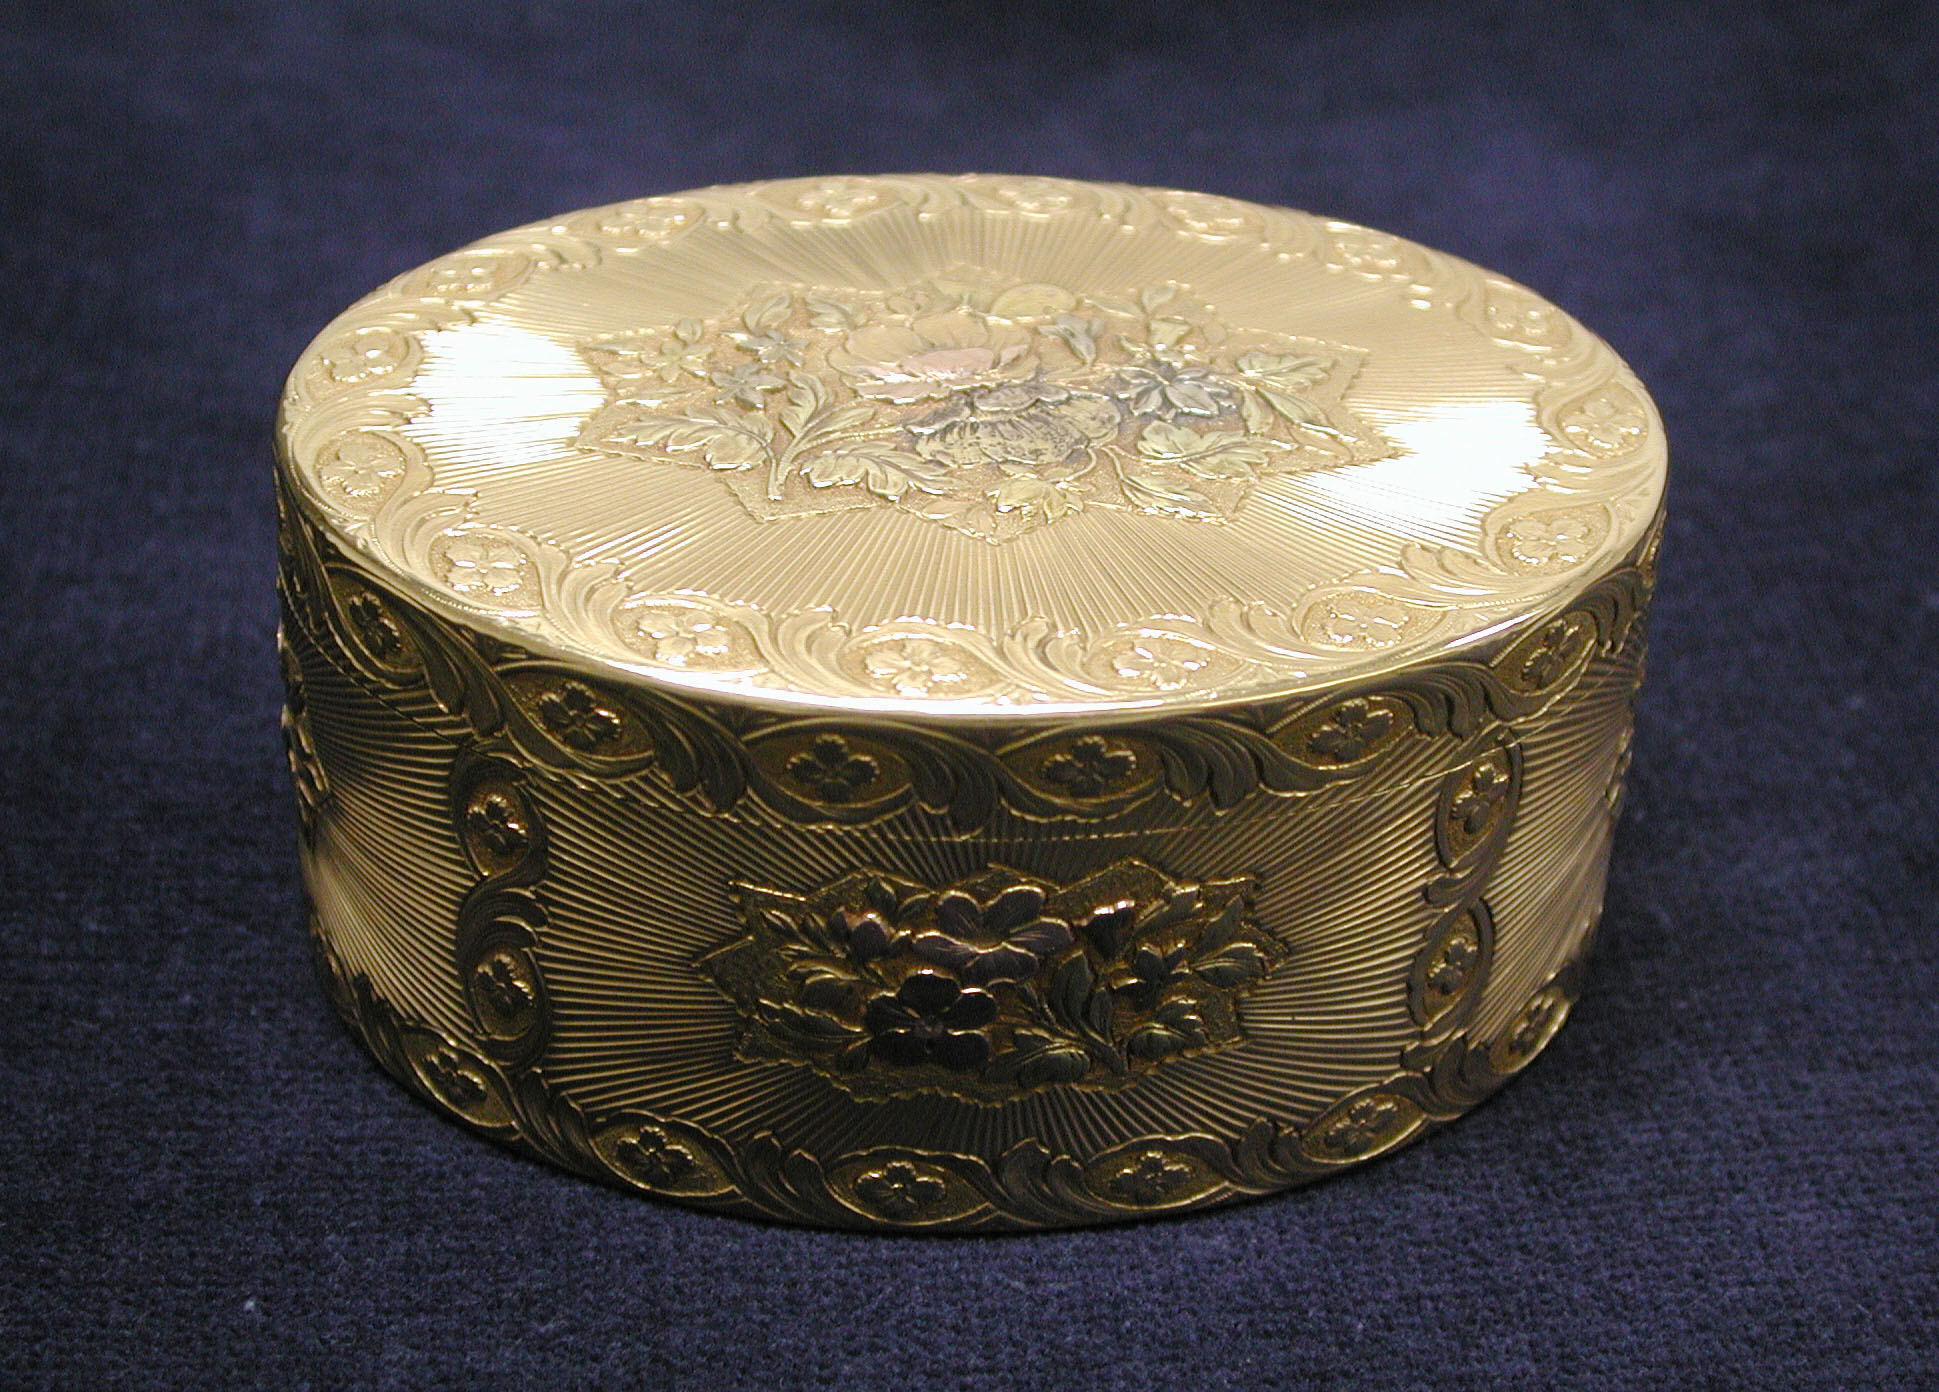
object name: snuffbox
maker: jean frémin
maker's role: maker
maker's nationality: french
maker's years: 1738-1786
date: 1757-1758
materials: gold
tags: flowers